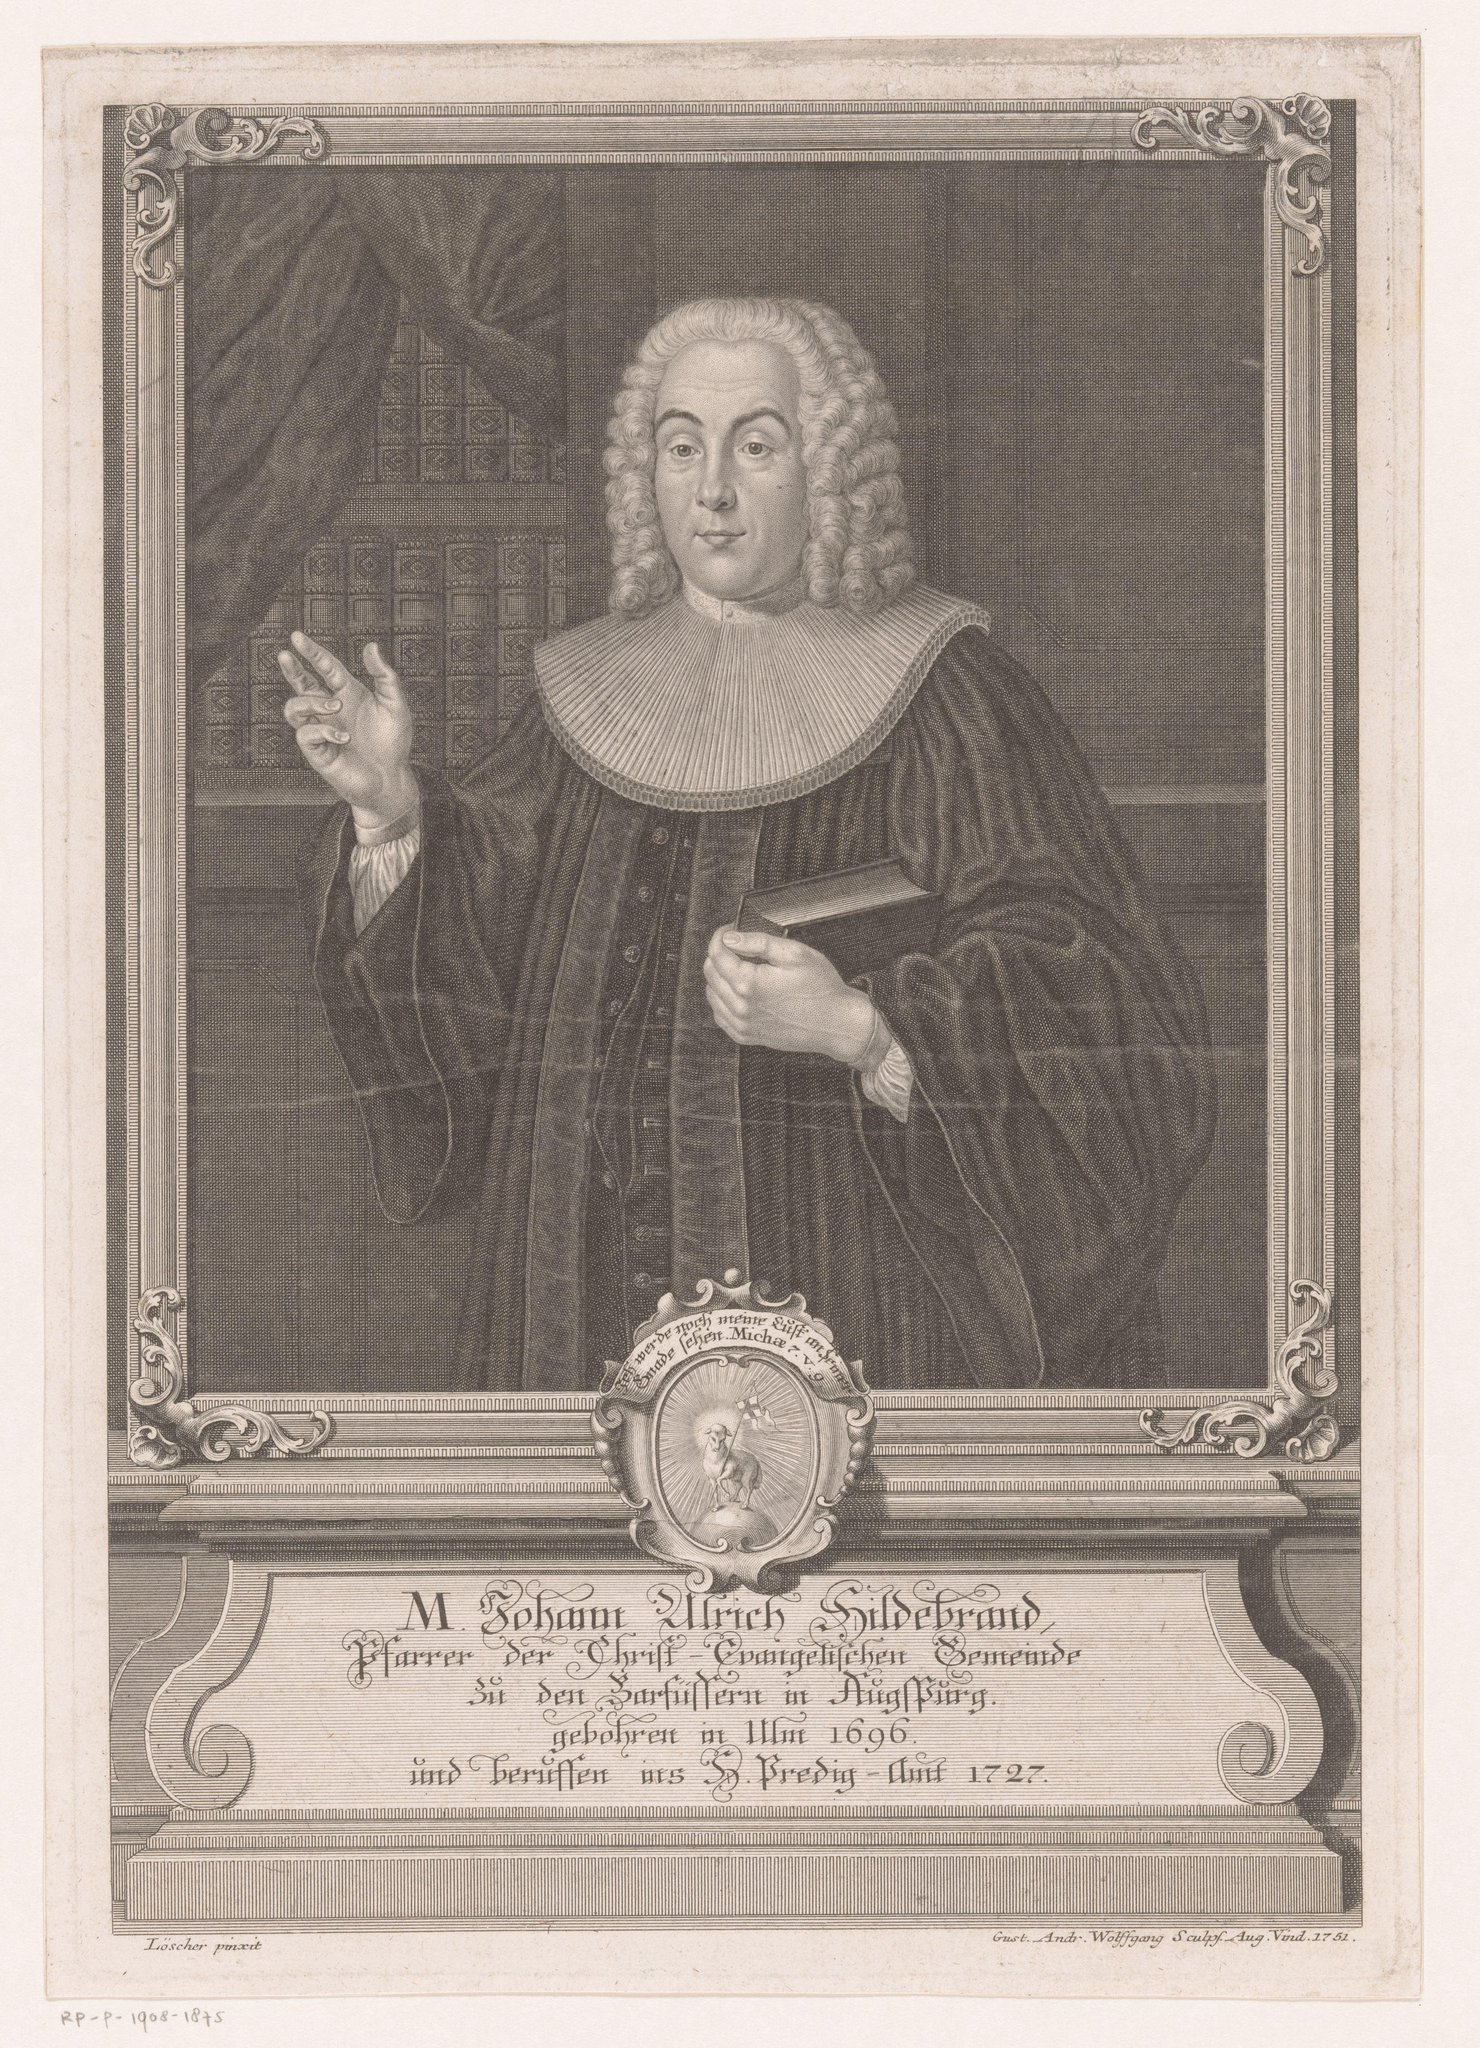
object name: print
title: Portret van Johann Ulrich Hildebrand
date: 1751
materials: paper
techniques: engraving, etching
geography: augsburg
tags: augsburg, historical persons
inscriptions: collector's mark: Lugt 2228, collector's mark: Lugt 9